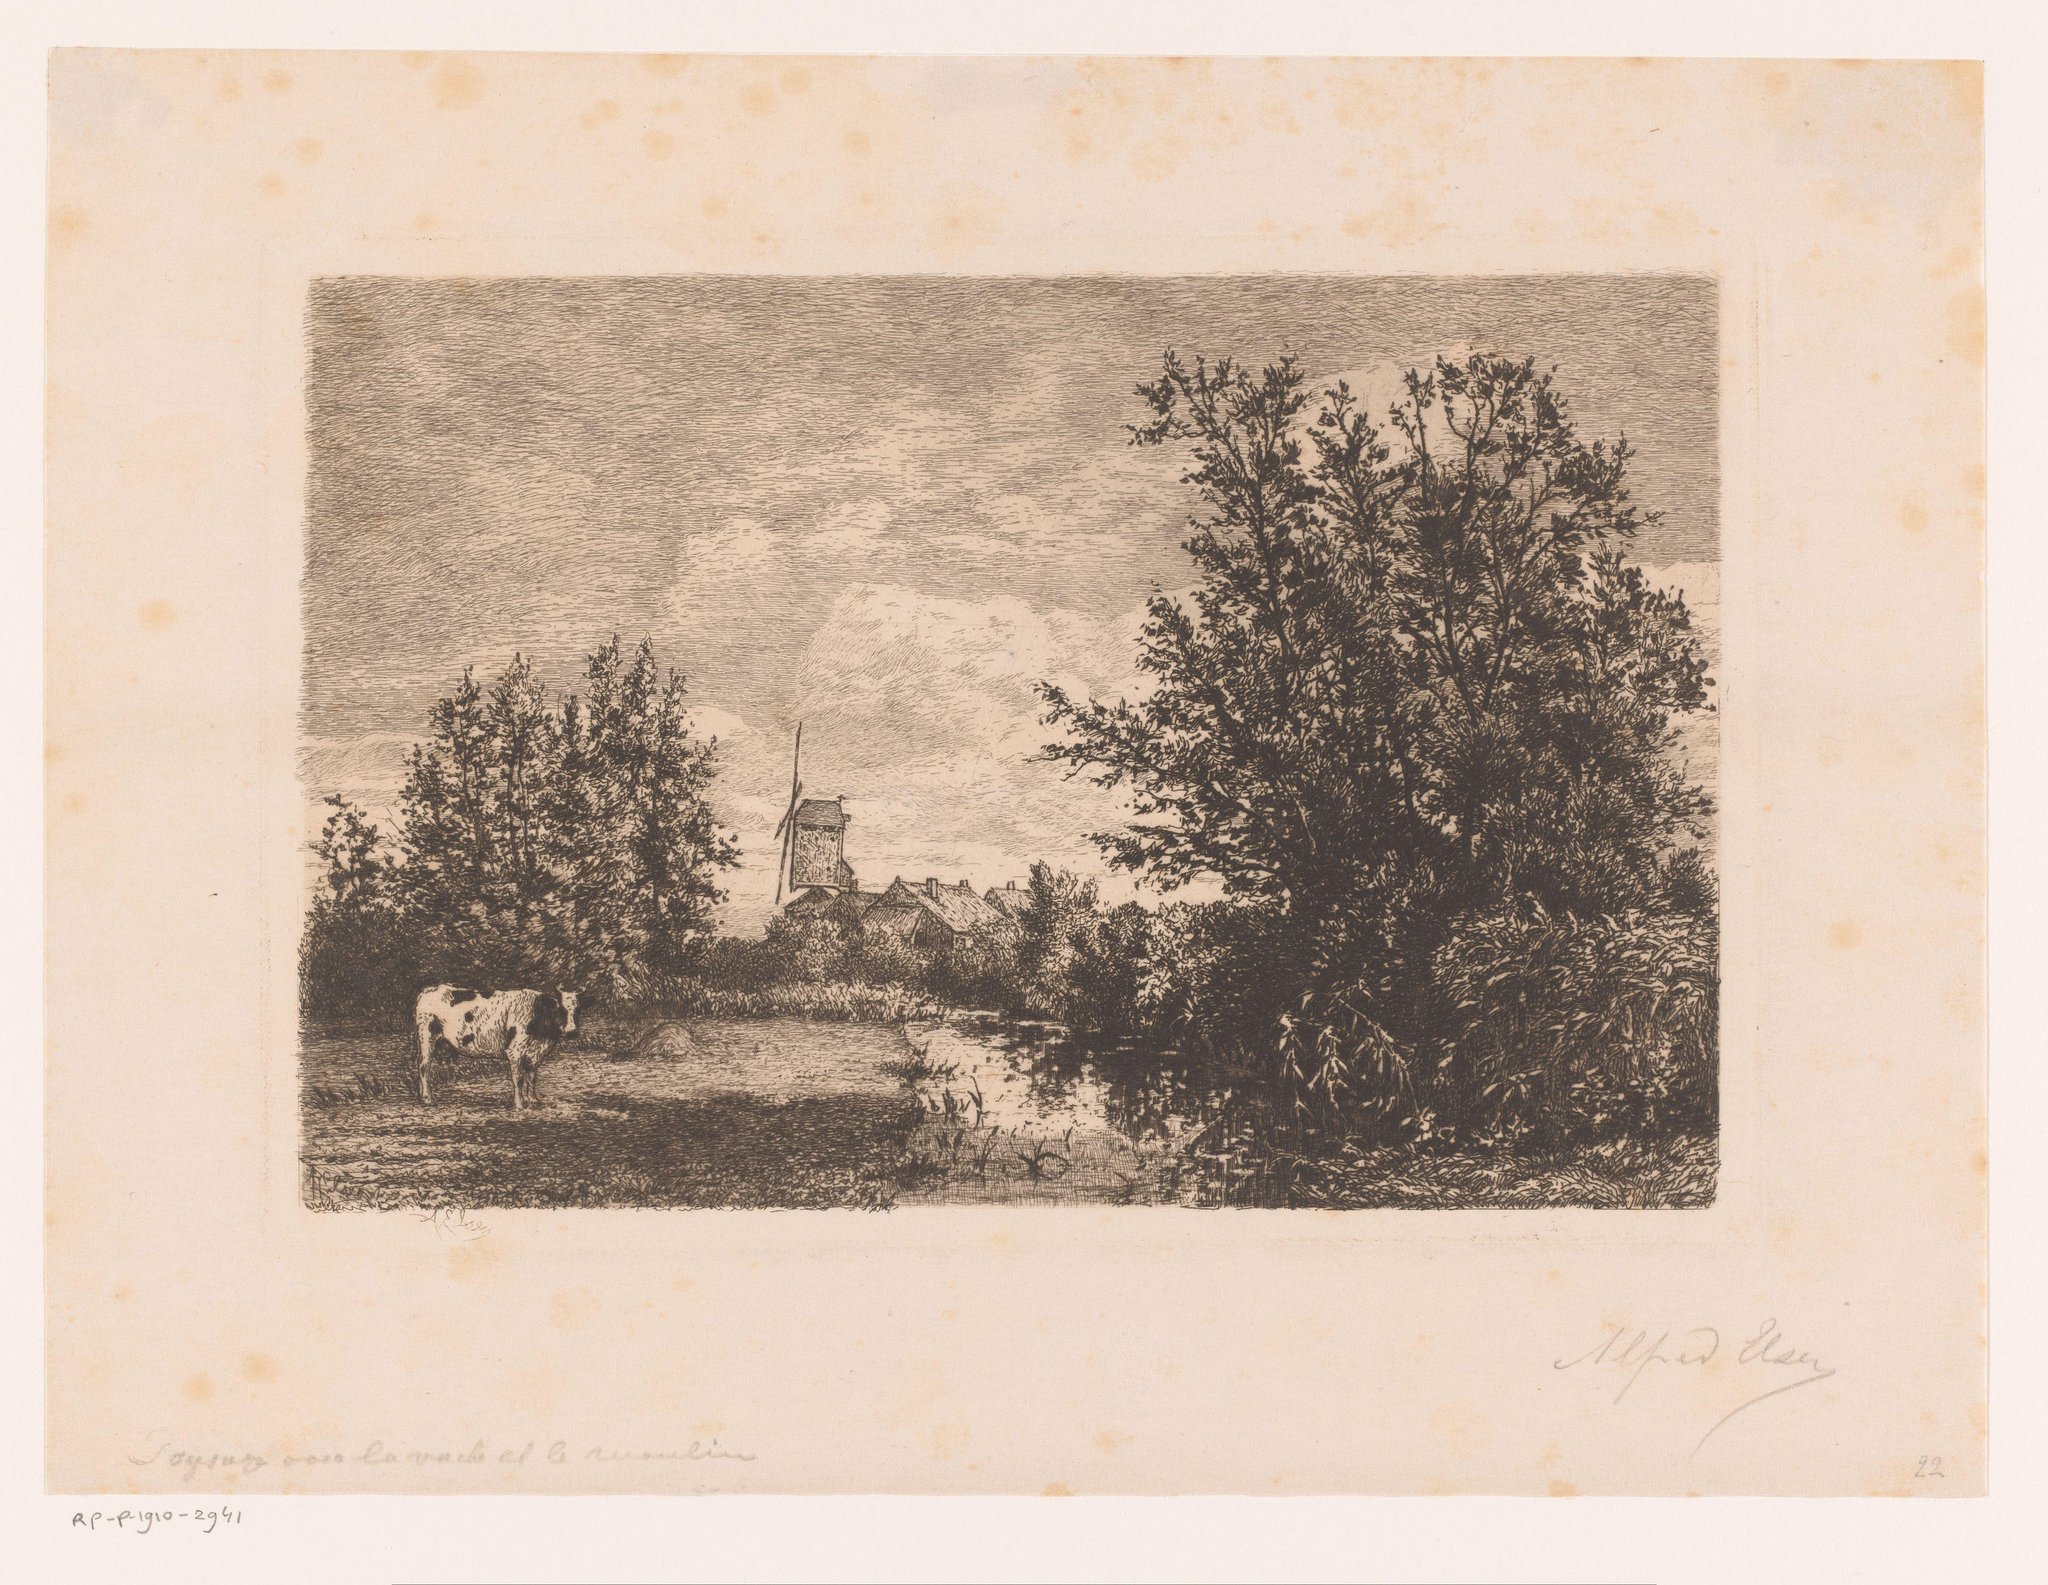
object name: print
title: Landschap met molen en koe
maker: alfred elsen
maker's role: painter, print maker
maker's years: 1850-1914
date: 1860-1910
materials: paper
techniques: etching, intaglio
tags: cow, windmill in landscape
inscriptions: collector's mark: Lugt 2228, mark: ‘Antwerpsche Etsers 1880’